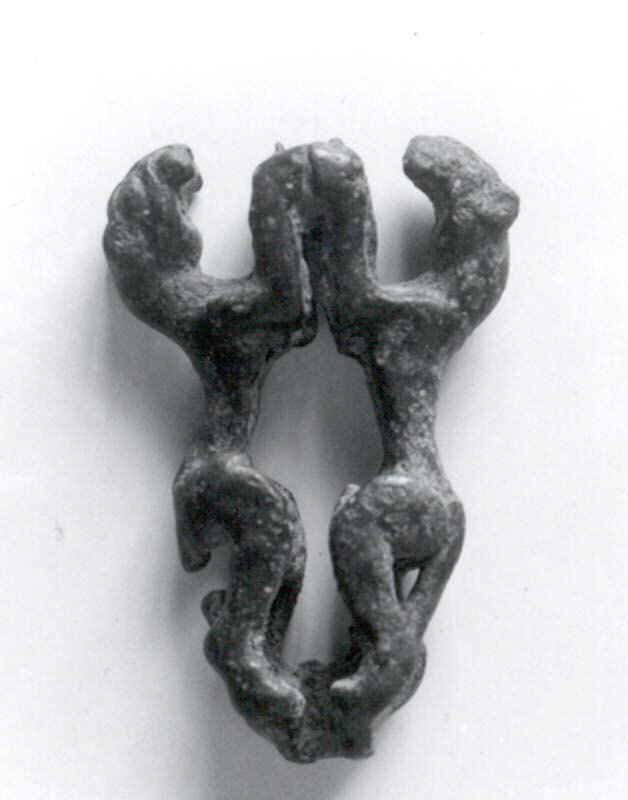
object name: standard top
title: Top for standard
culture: iranian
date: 800-601 BCE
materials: bronze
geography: iran, probably from luristan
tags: animals